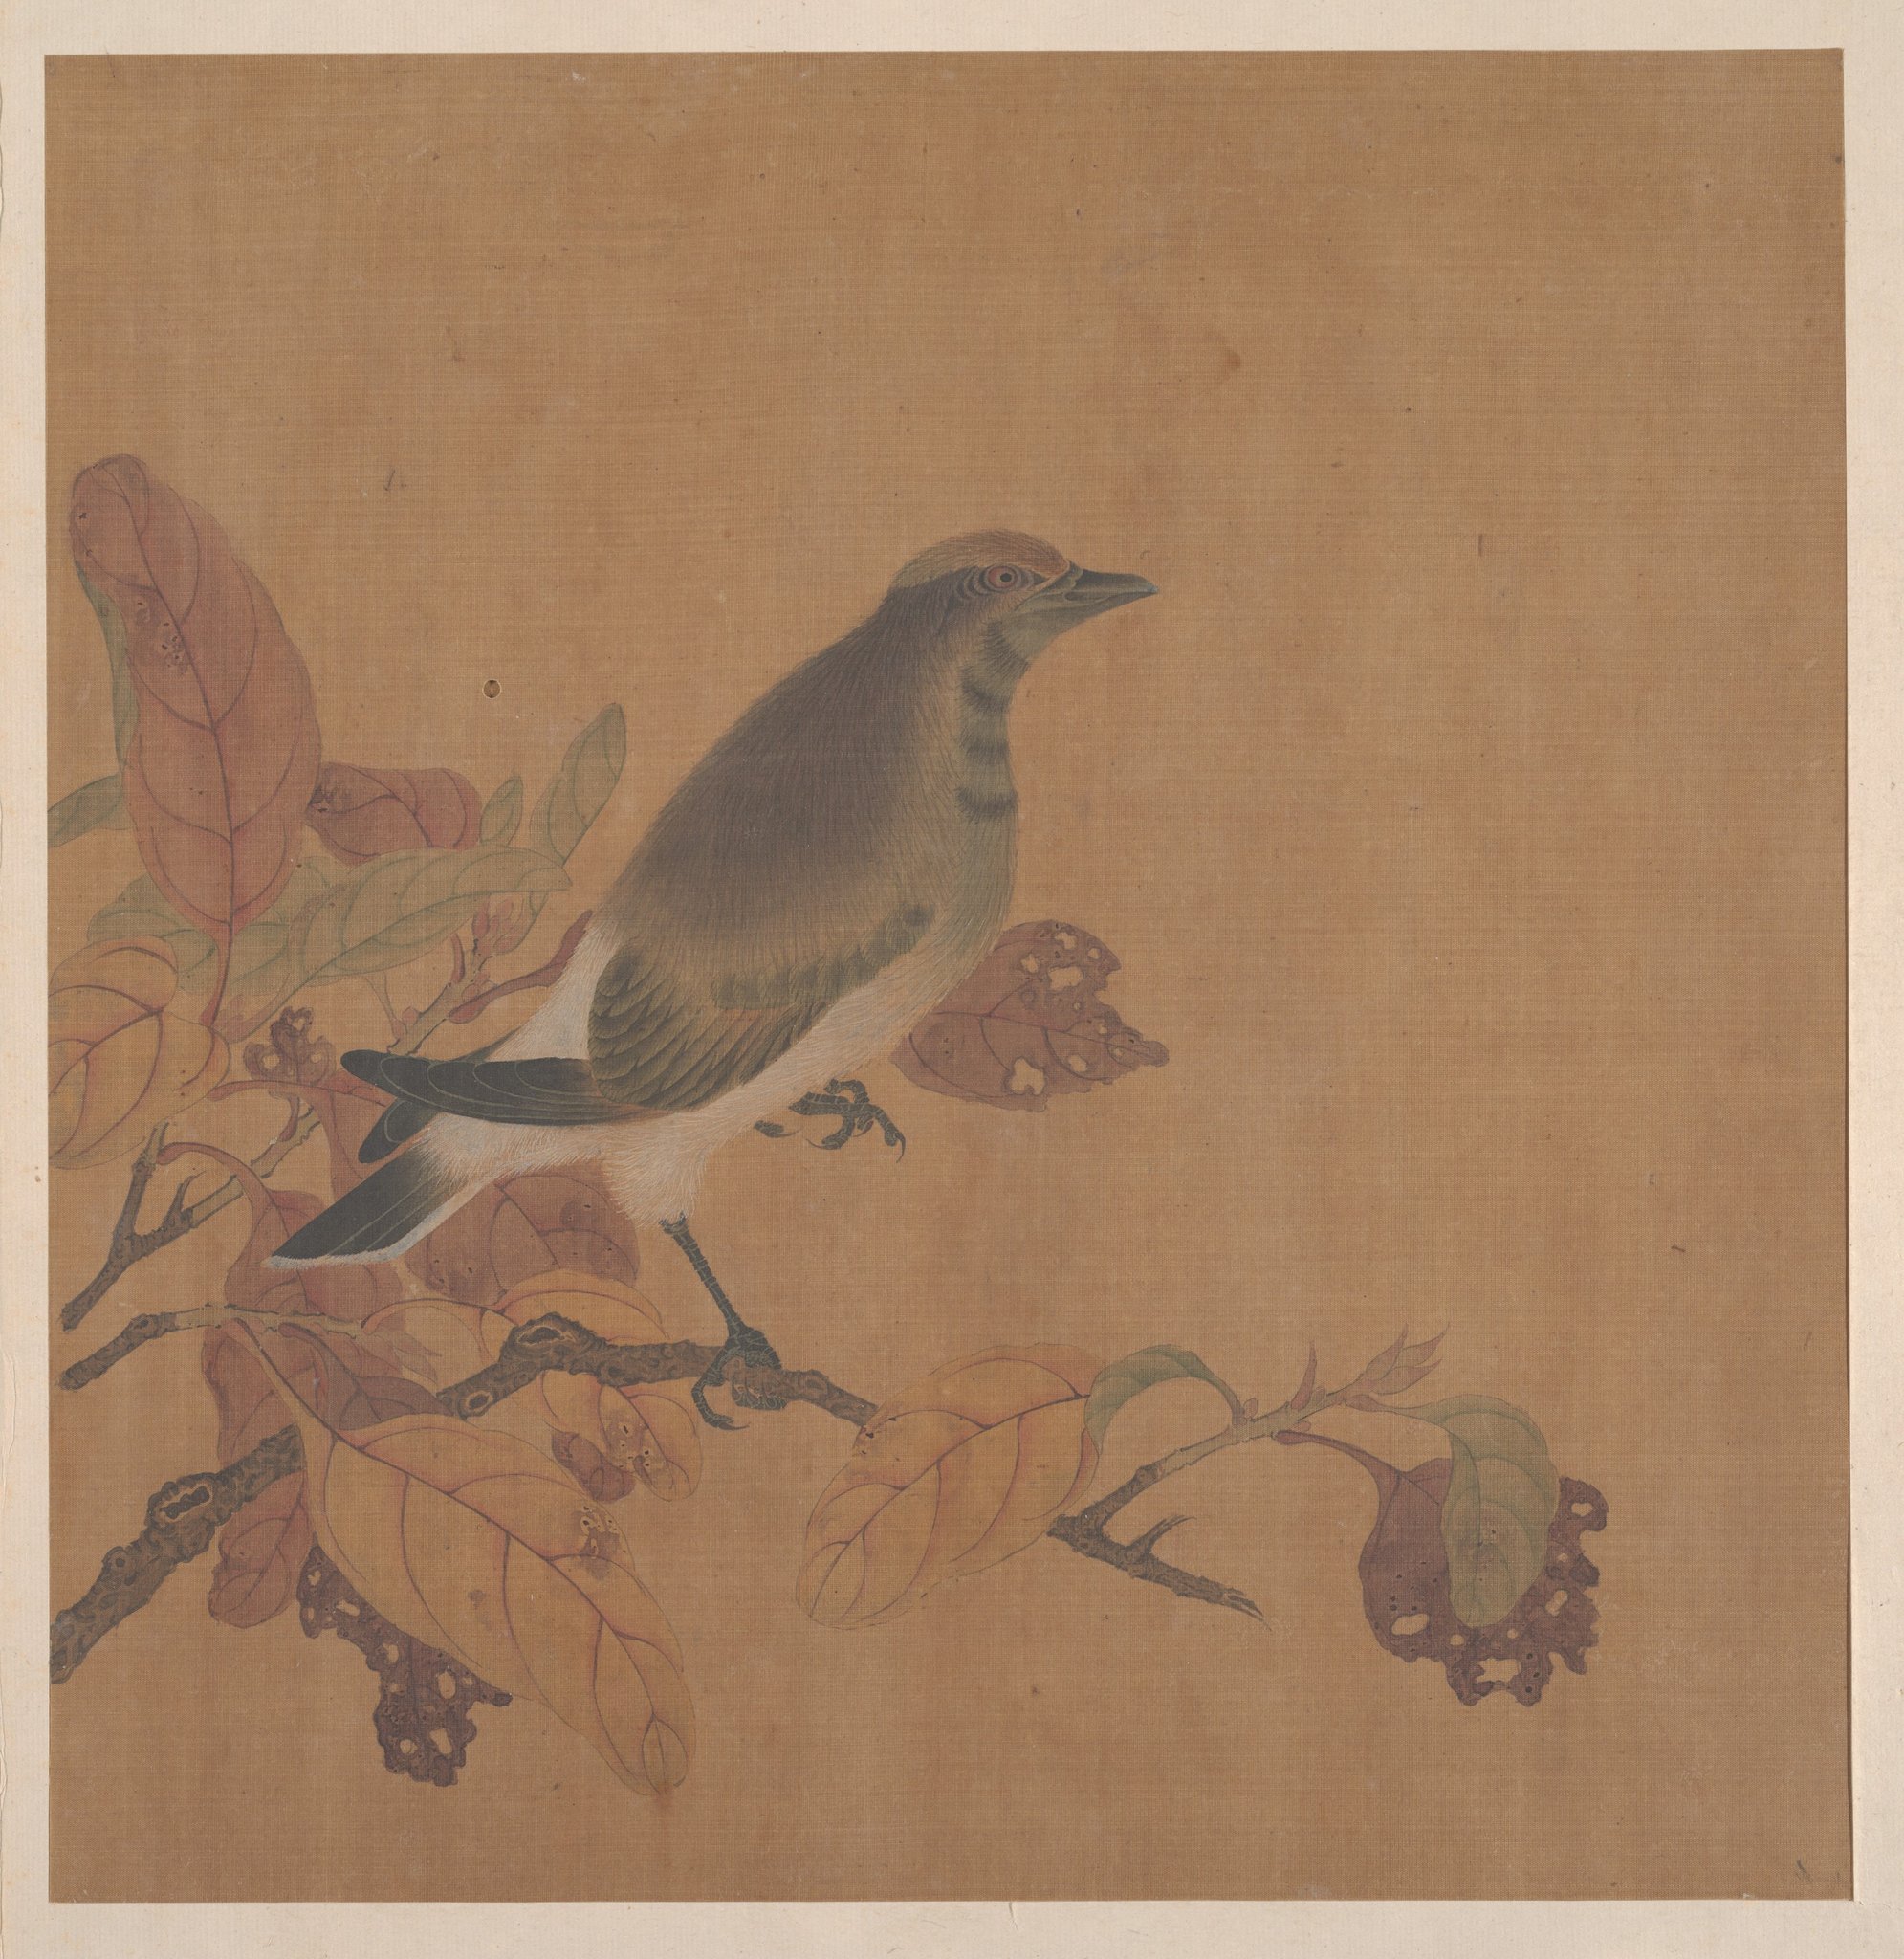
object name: fan mounted a an album leaf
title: Bird on Branch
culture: chinese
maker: unidentified artist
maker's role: artist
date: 1644-1911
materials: ink, silk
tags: birds,leaves